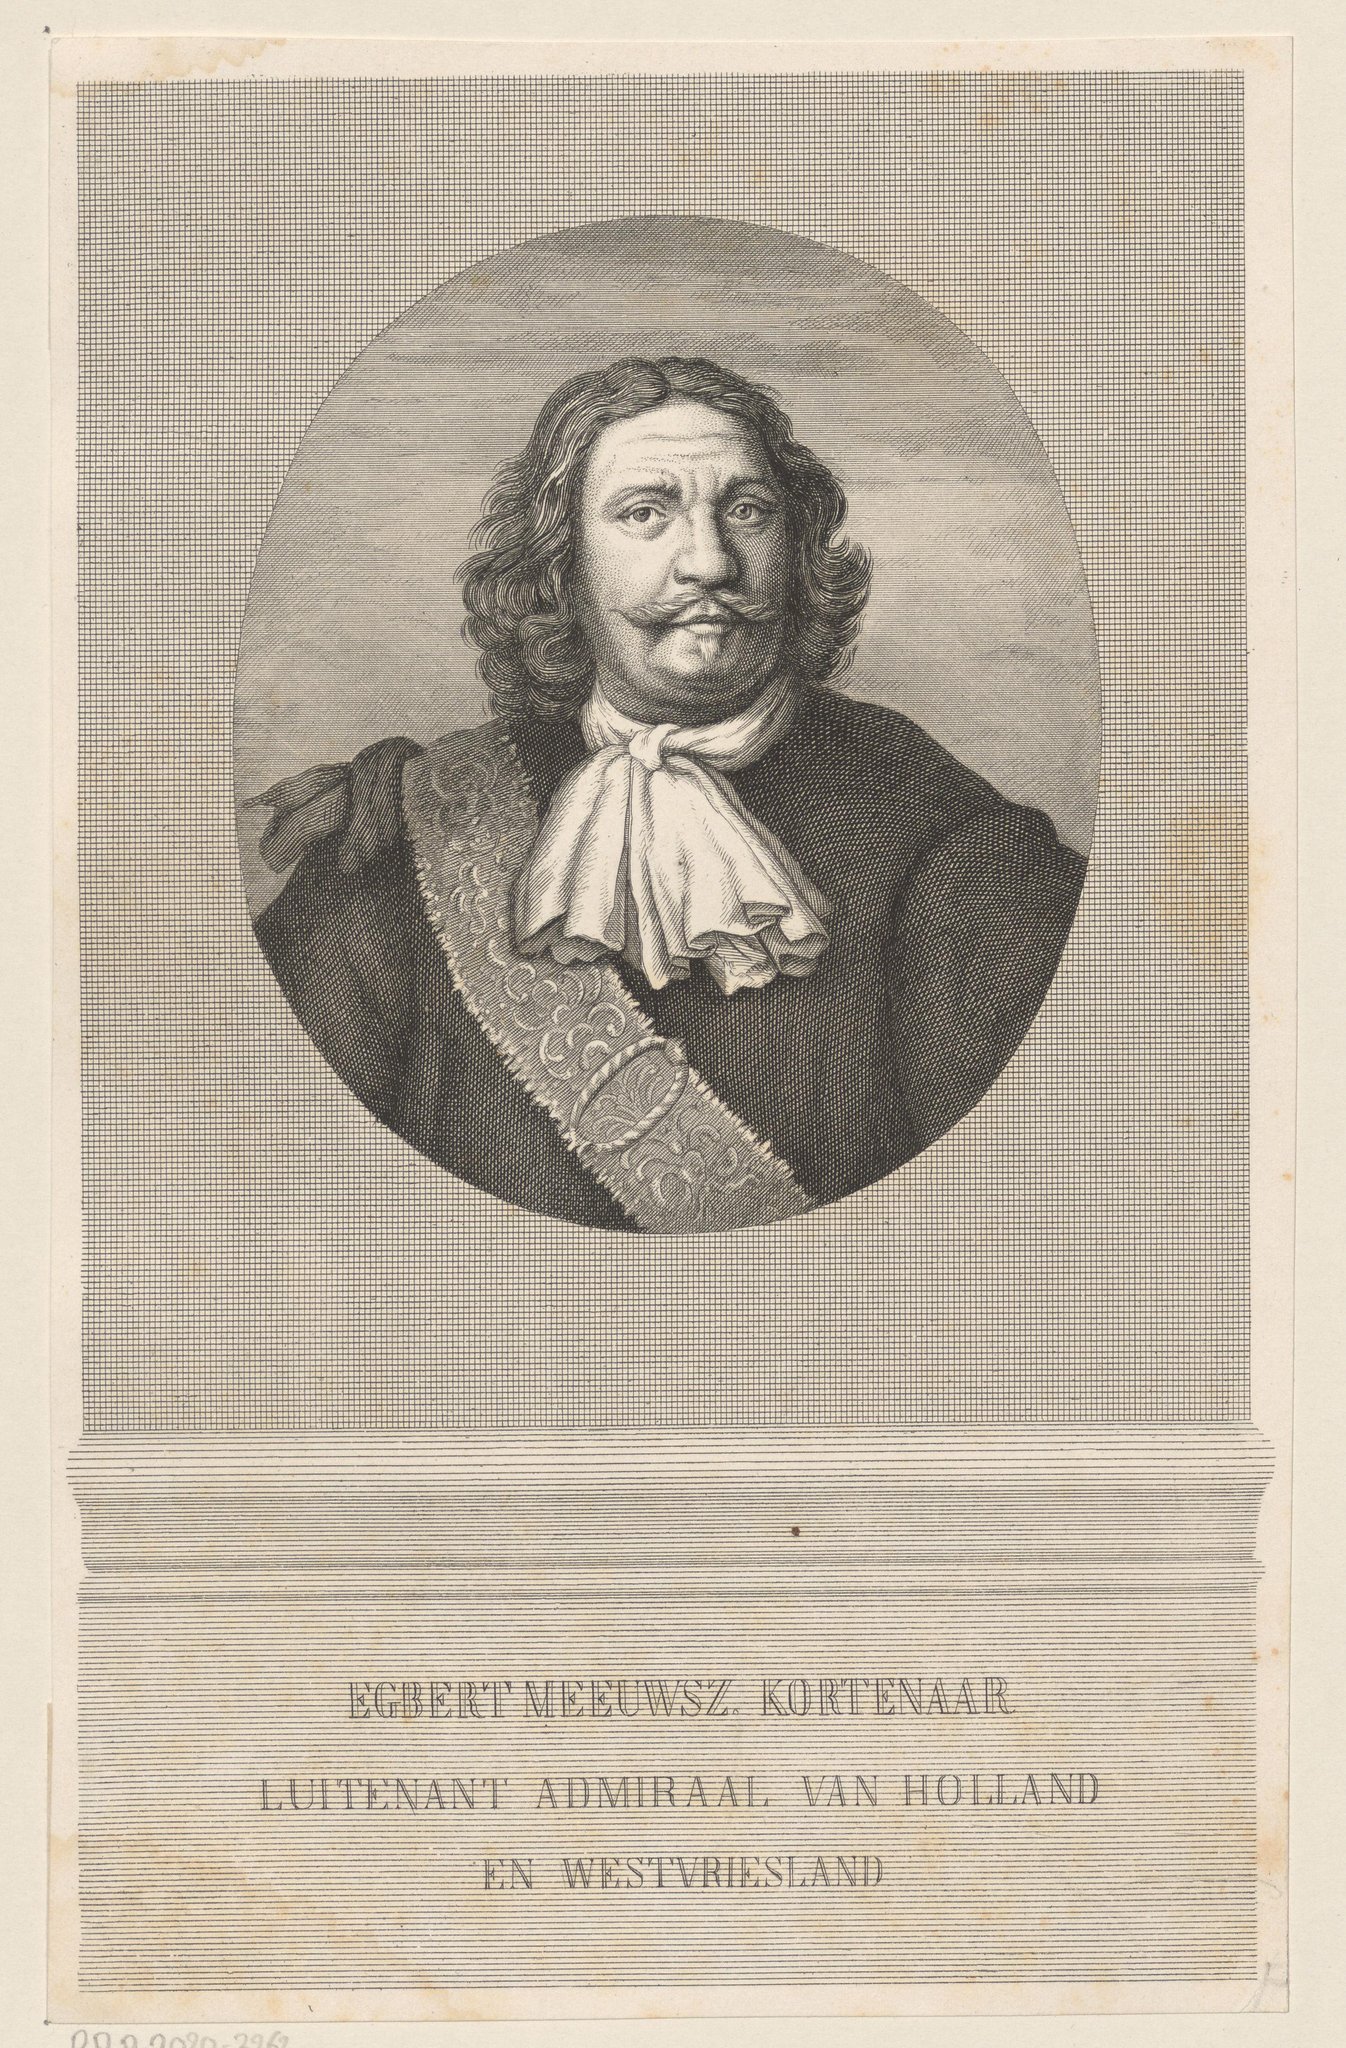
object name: print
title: Portret van Egbert Meeusz Kortenaer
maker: Anonymous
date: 1700-1799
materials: paper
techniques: engraving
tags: historical persons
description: Prent mogelijk uit: Arend, Johannes Pieter. Algemeene geschiedenis des vaderlands: van de vroegste tijden tot op heden. Haarlem: Johannes de Haan, 1879, dl. 4, p. 728.